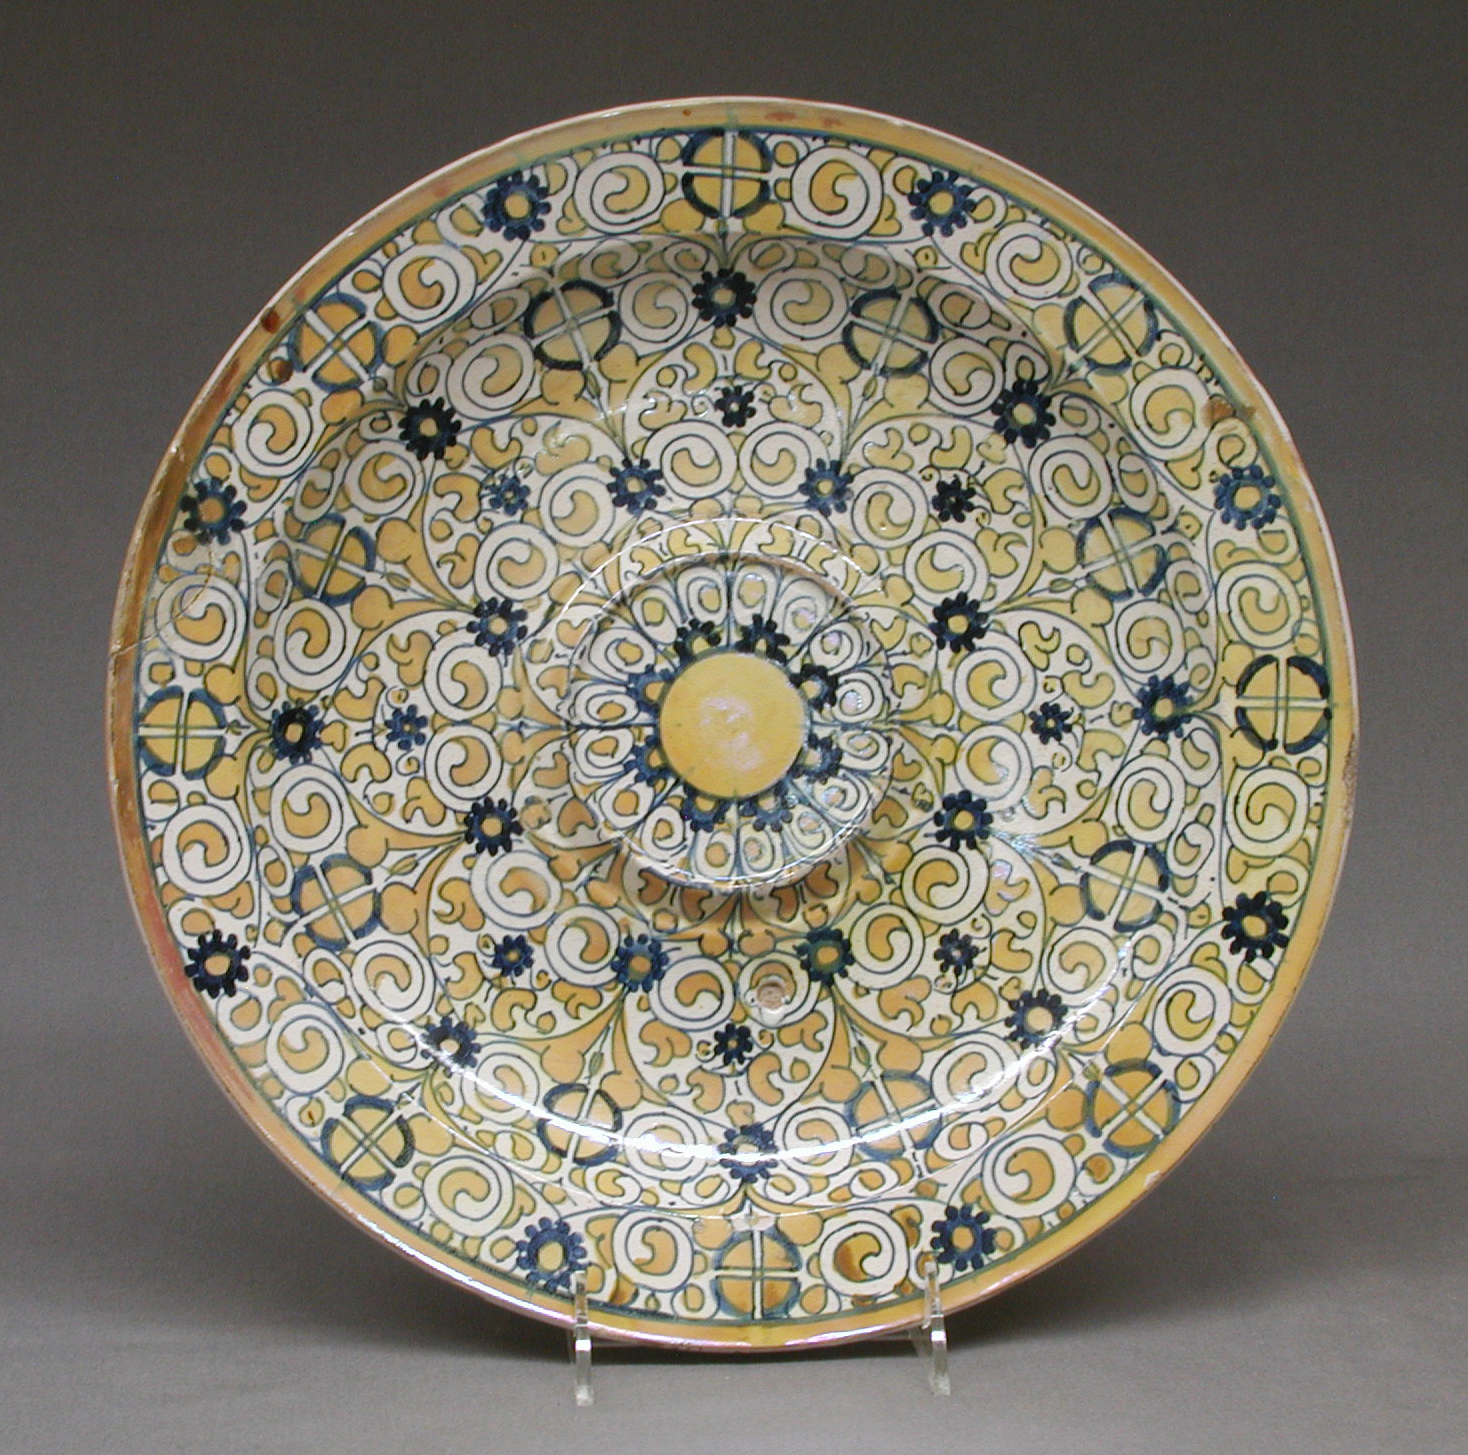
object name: ewer dish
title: Dish for a ewer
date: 1515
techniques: maiolica, glazing